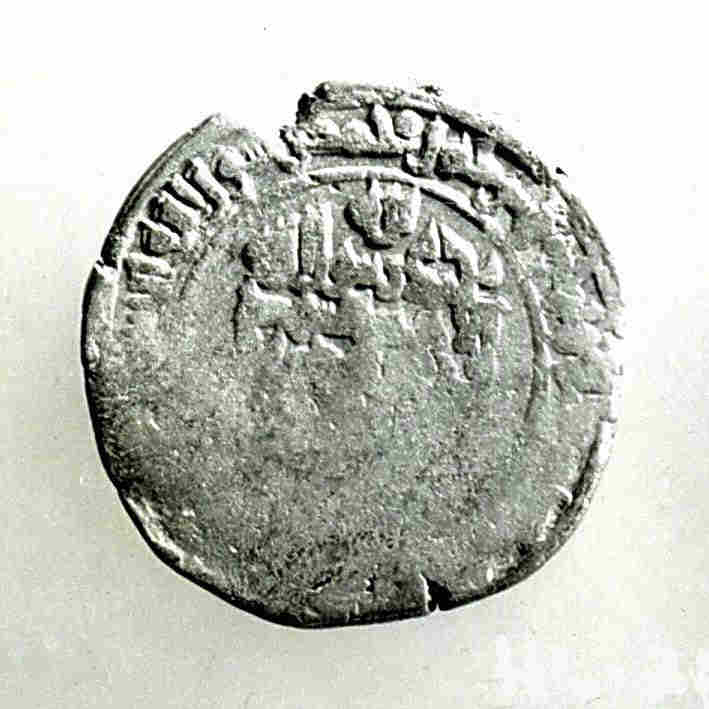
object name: coin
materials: silver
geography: iran